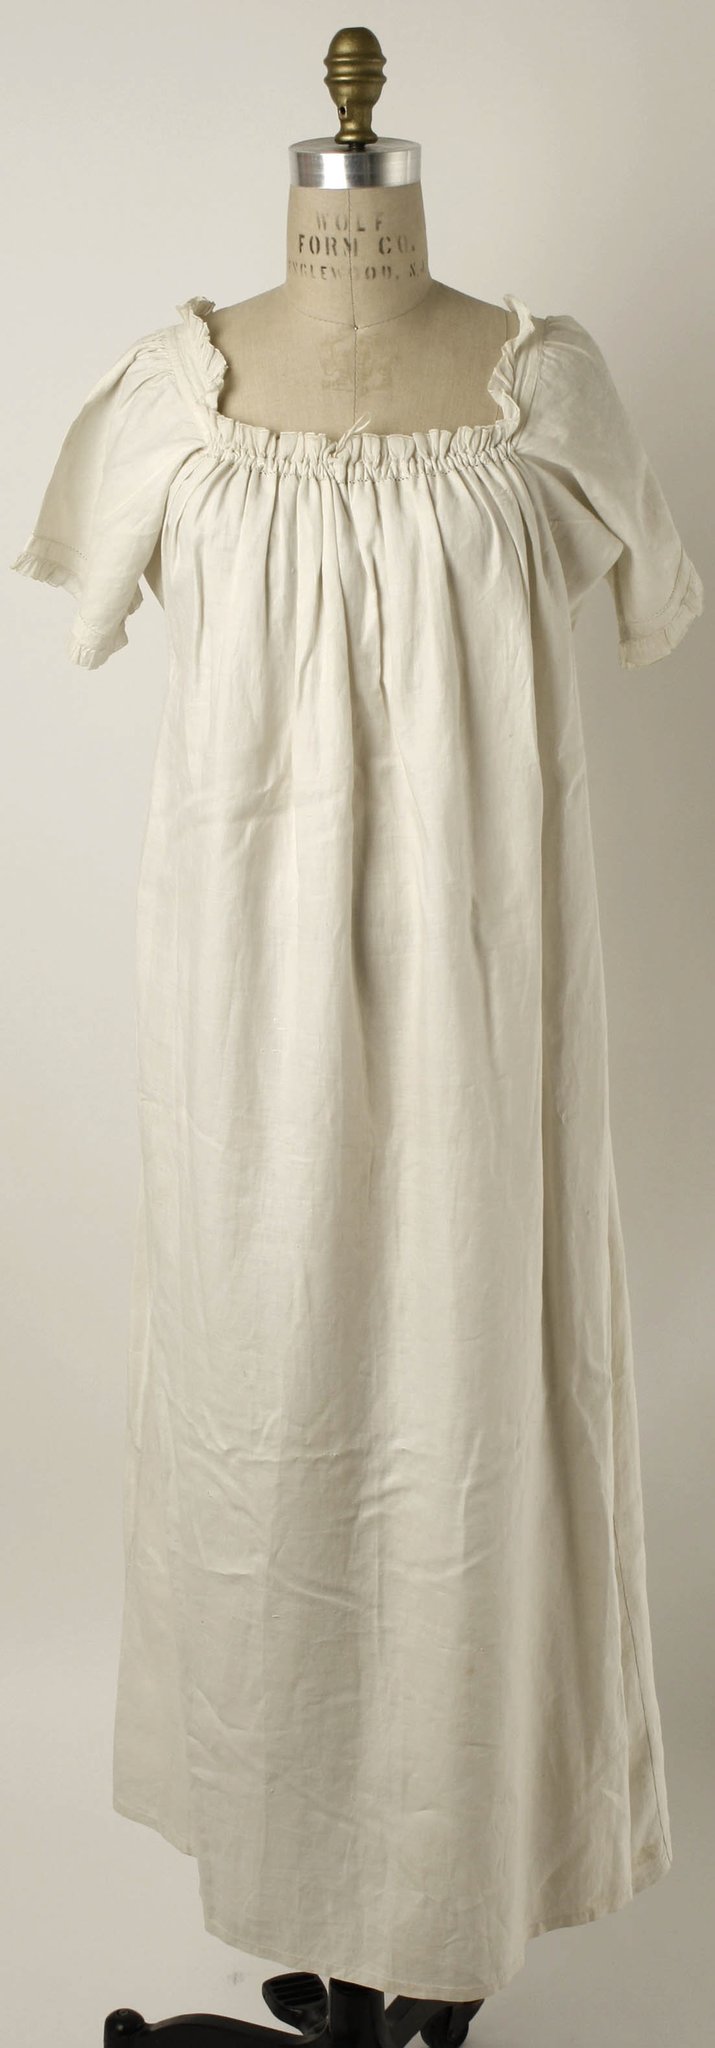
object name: chemise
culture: american or european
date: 1810-1819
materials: linen